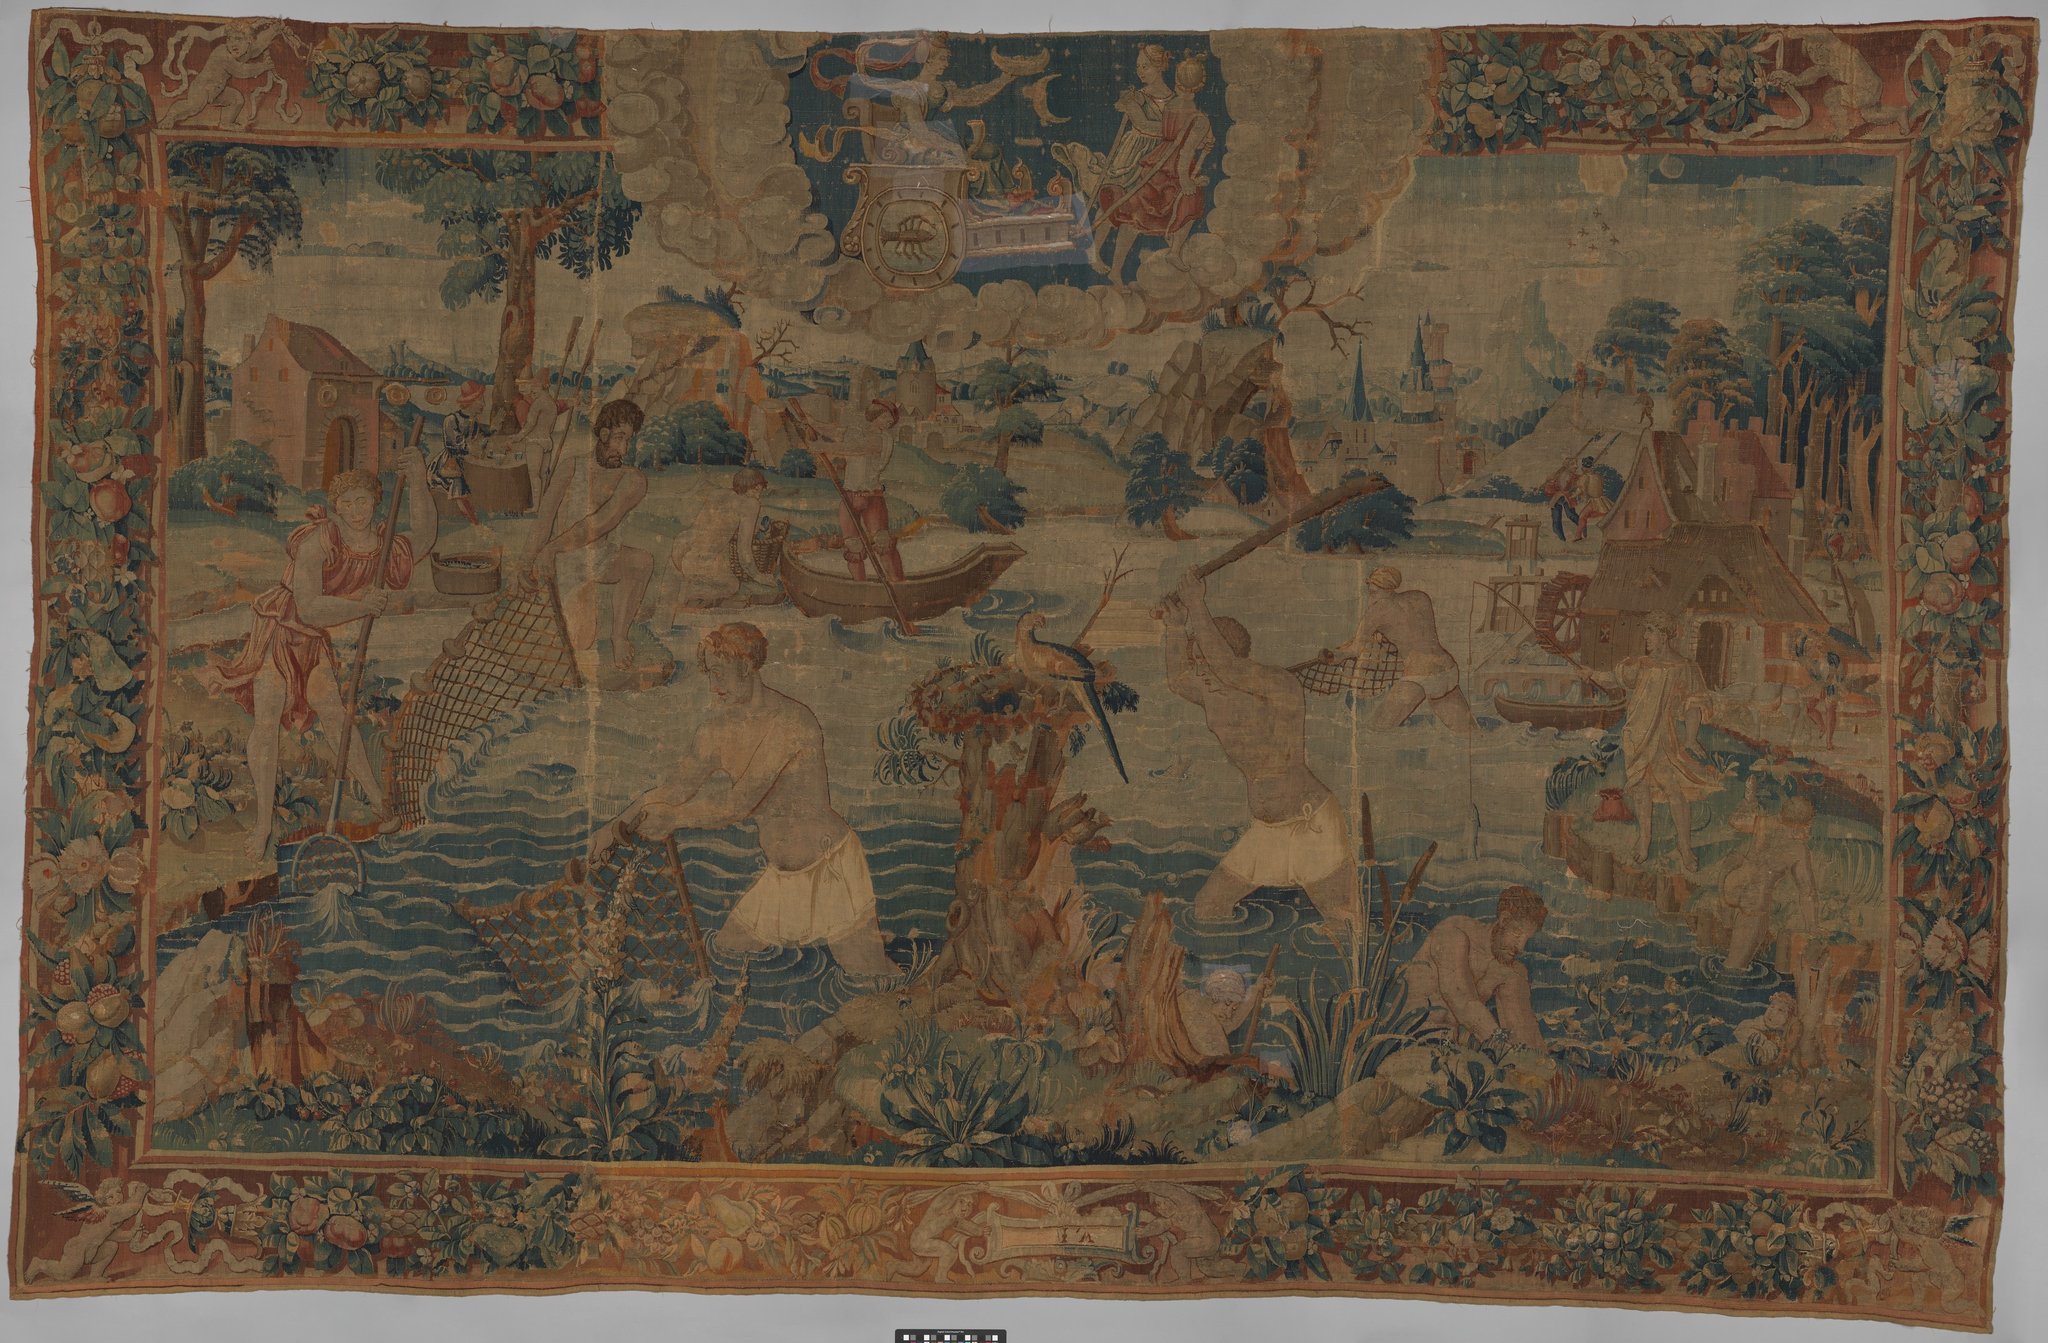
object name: tapestry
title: The Moon and Her Children from a Set of the Planets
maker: barthel beham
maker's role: artist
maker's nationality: german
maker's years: 1502-1540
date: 1534-1566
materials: wool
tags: houses,men,trees,working,boats